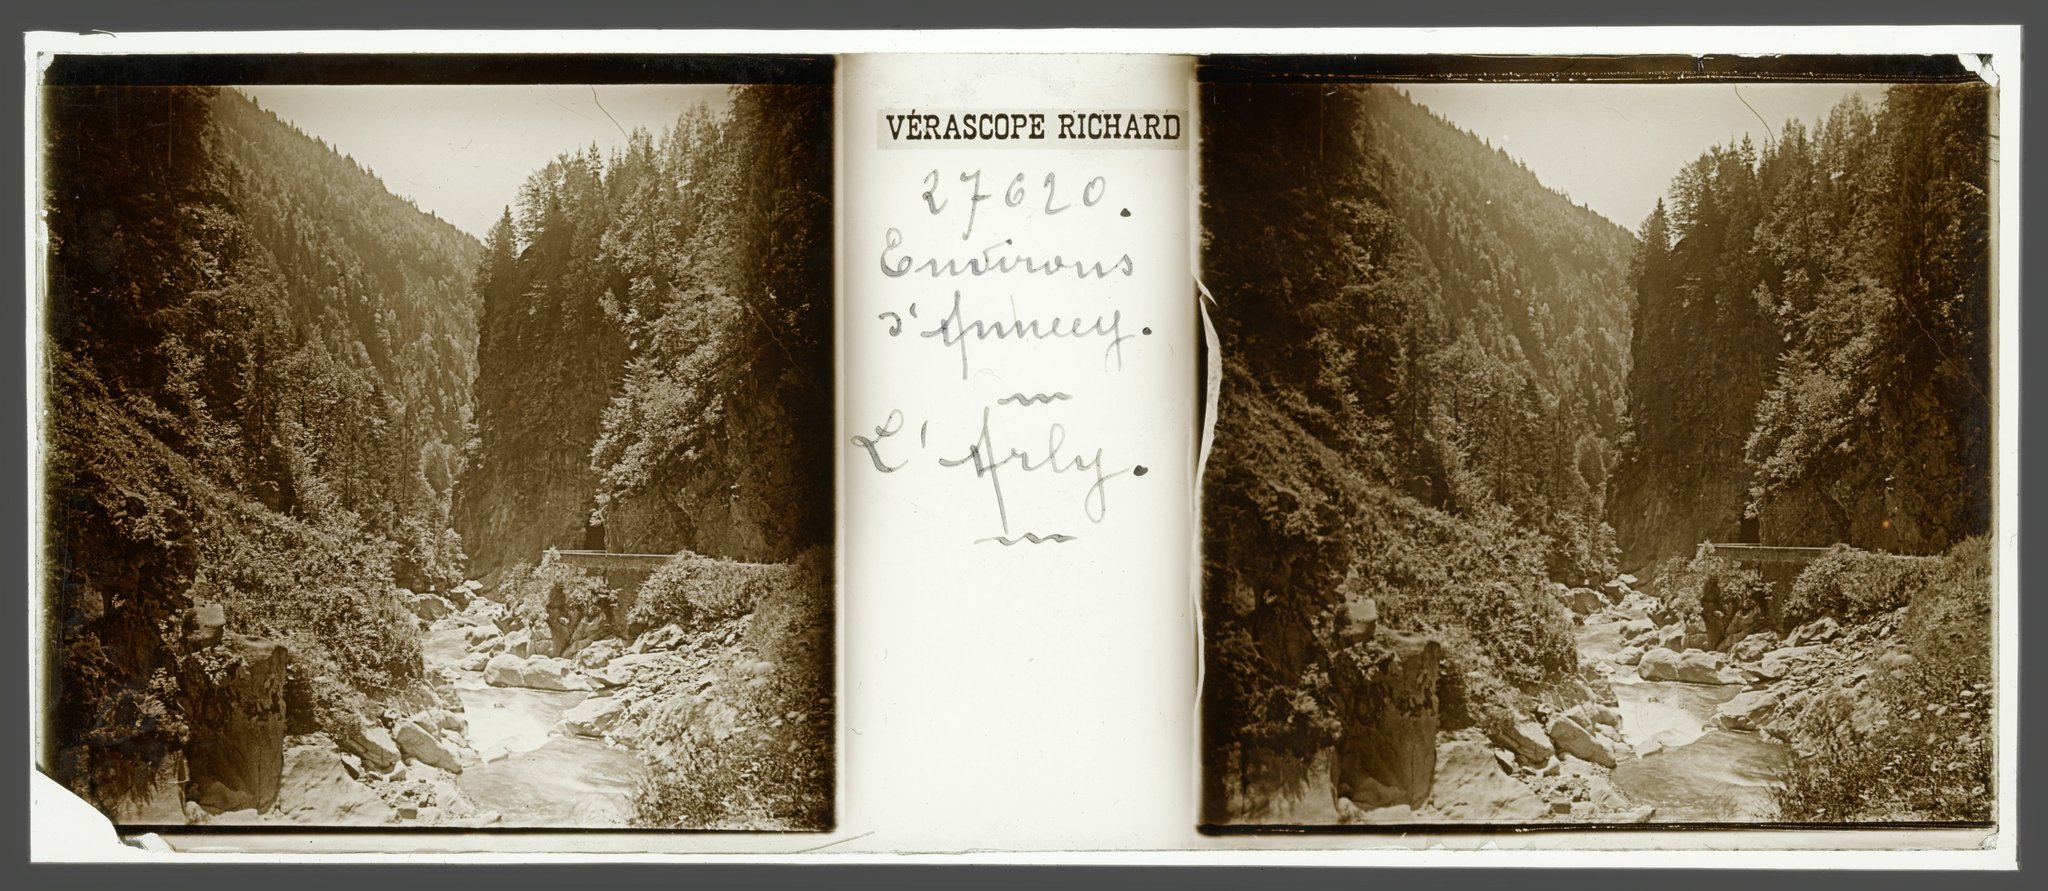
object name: stereoscopic photograph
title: Environs d'Annecy - L'Arly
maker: Anonymous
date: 1893-1920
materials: glass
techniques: gelatin silver transparency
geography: paris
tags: brook, mountains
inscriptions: number: ‘27620’